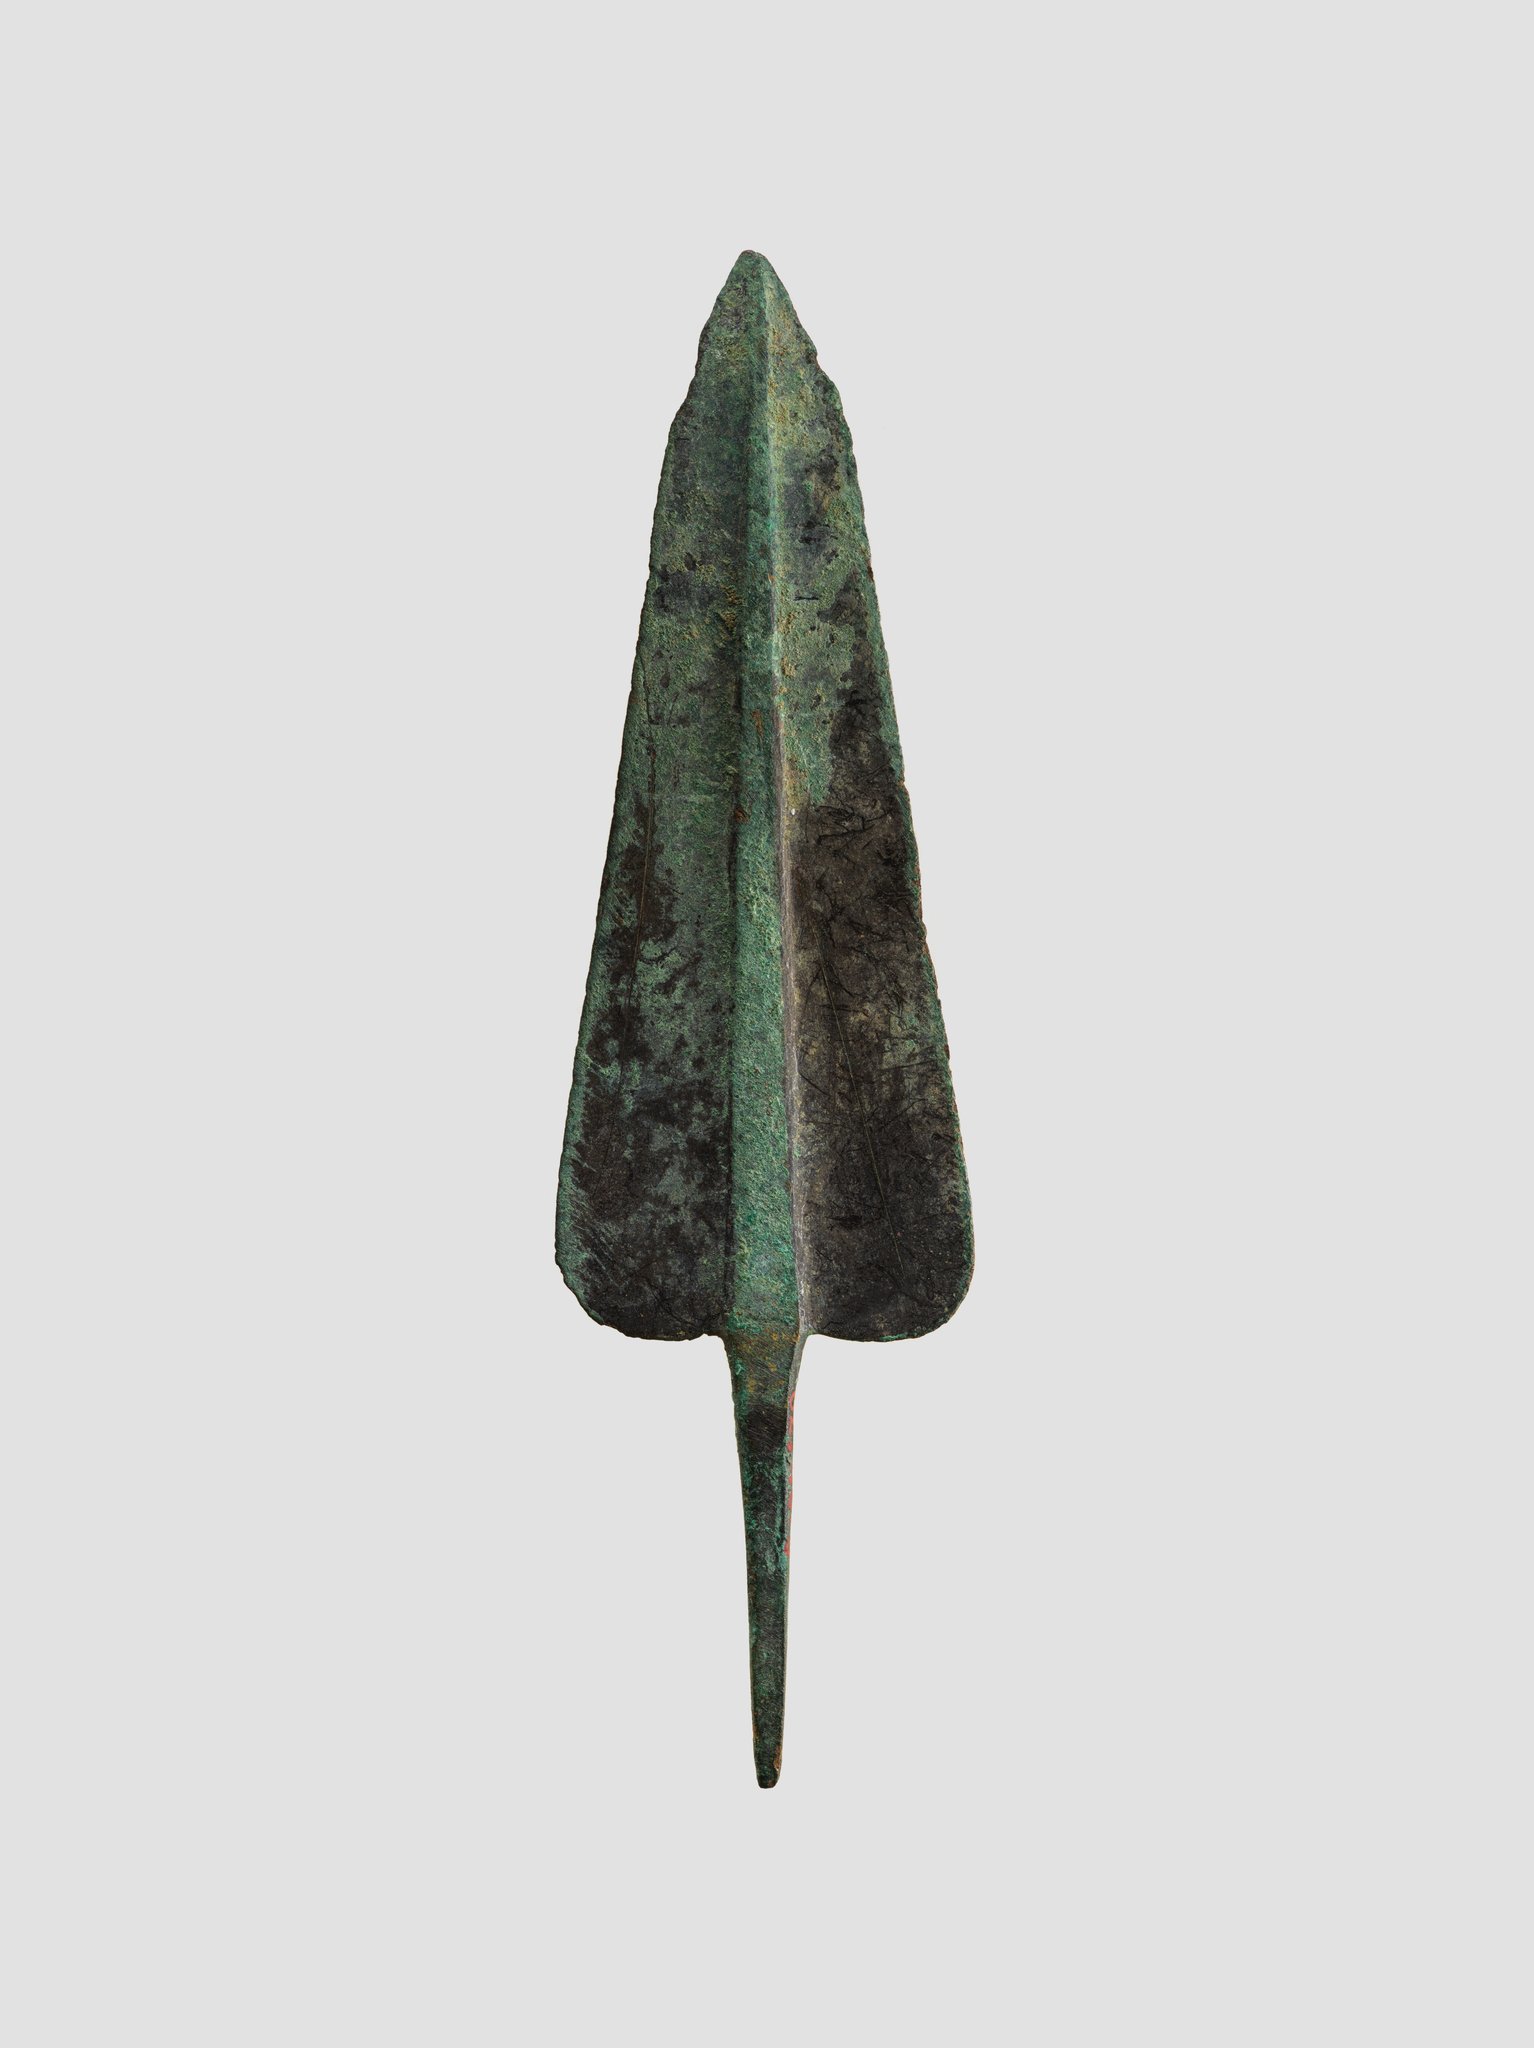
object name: arrowhead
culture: iranian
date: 2000-1 BCE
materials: bronze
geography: iran